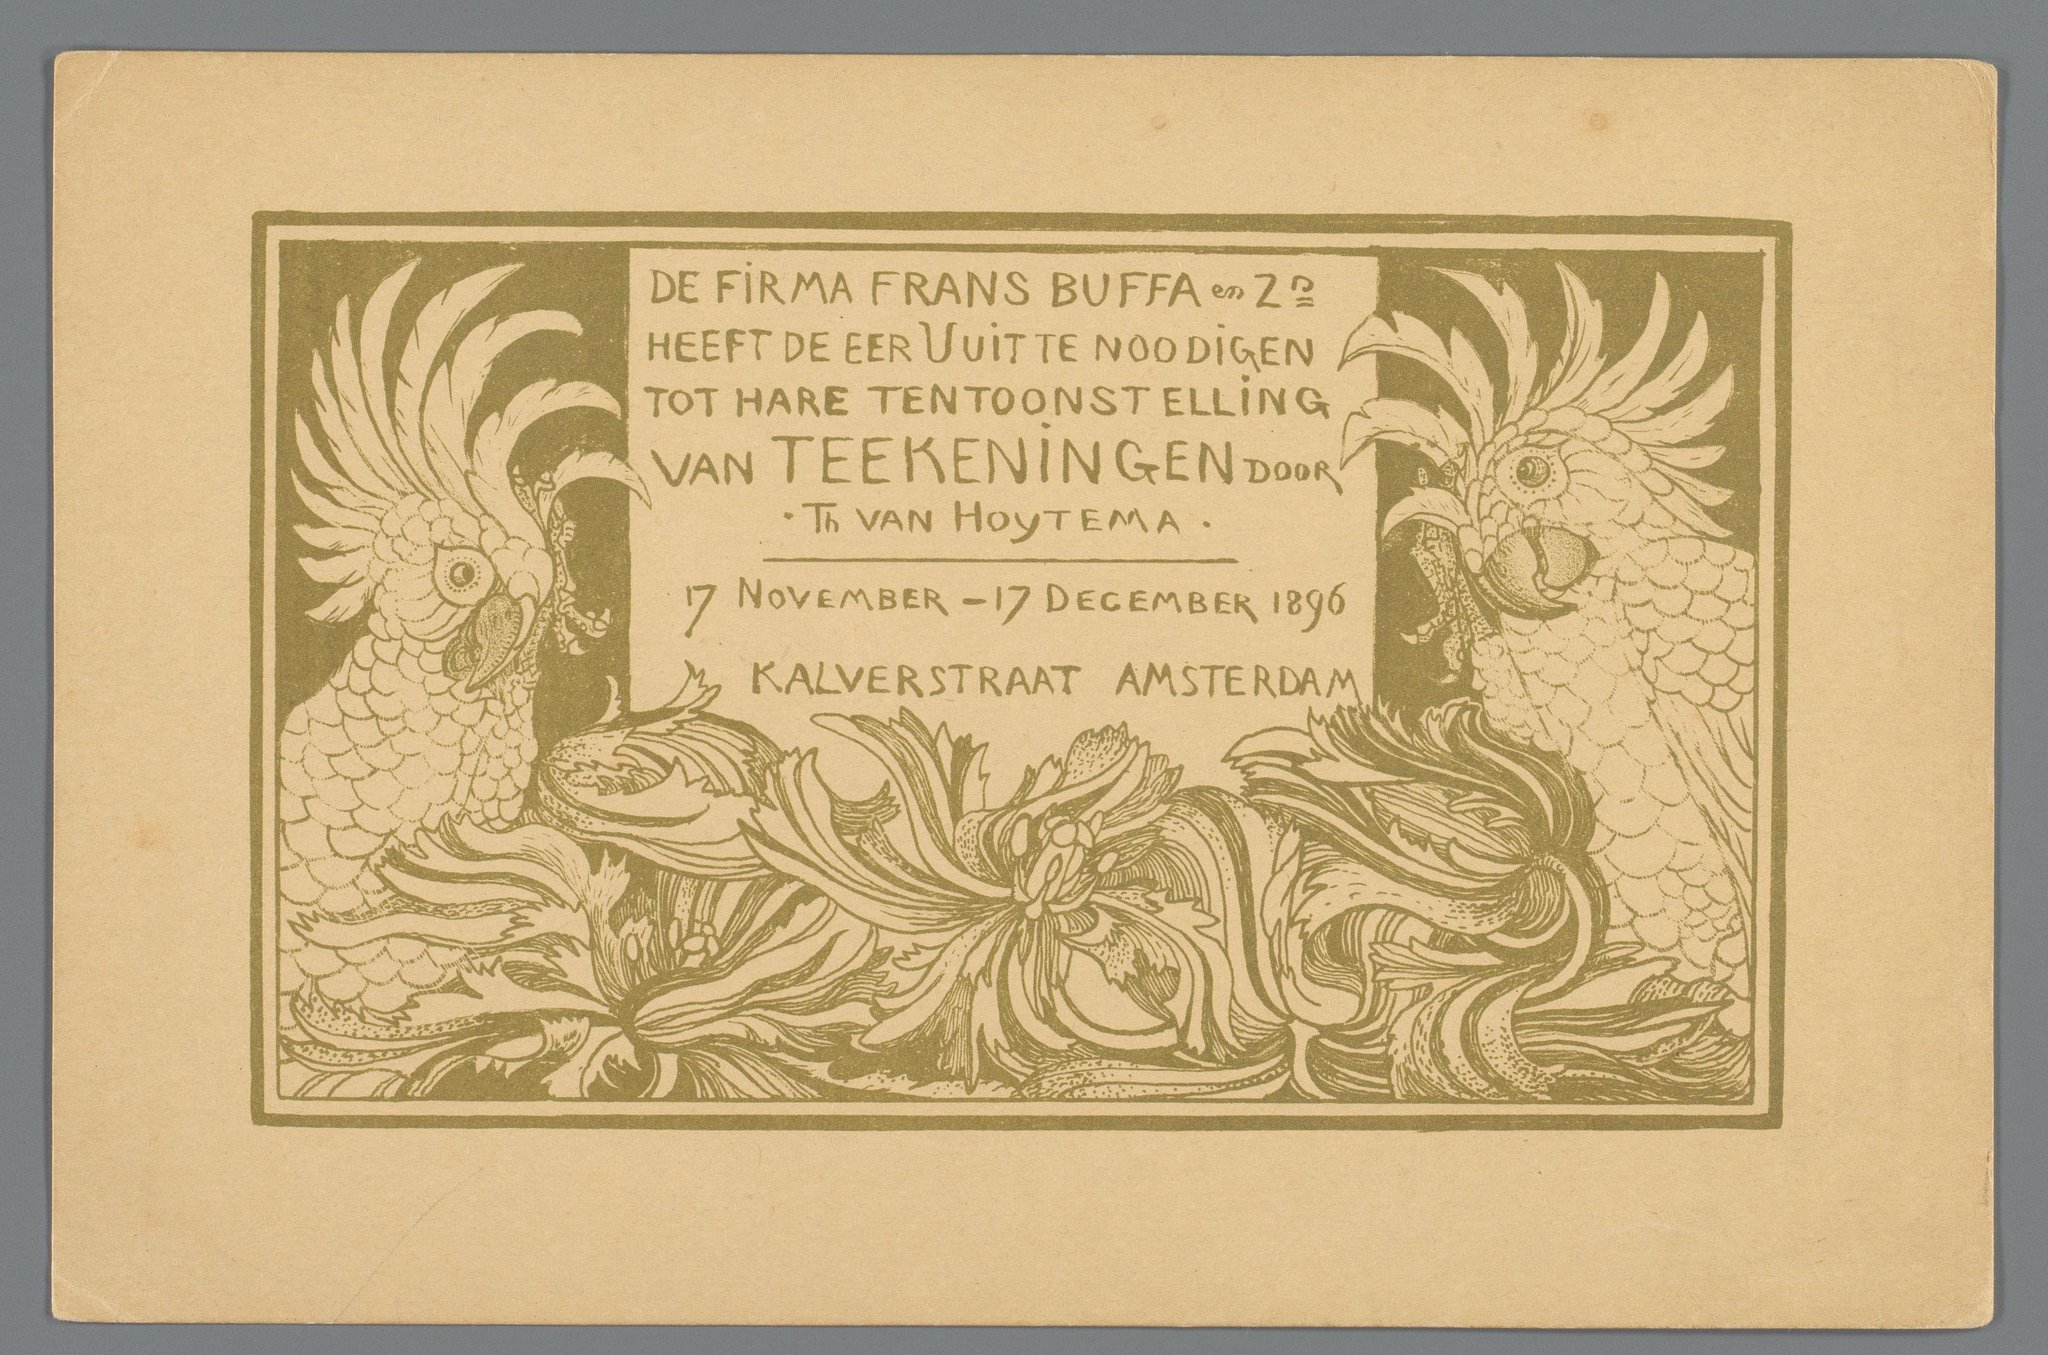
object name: print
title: Uitnodiging voor de tentoonstelling van tekeningen door Theo van Hoytema bij firma Frans Buffa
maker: theo van hoytema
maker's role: draughtsman, painter, print maker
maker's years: 1863-1917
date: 1896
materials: paper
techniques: lithograph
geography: amsterdam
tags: the hague, painter, print maker, draughtsman, theo van hoytema, ornamental birds: cockatoo, collection, exhibition, show, amsterdam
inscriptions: collector's mark: Lugt 2228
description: Twee kaketoes aan weerszijden van de tekst: 'De Firma Frans Buffa en Zn. heeft de eer U uit te noodigen tot hare tentoonstelling van teekeningen door Th. van Hoytema. 17 november - 17 december 1896, Kalverstraat Amsterdam'.